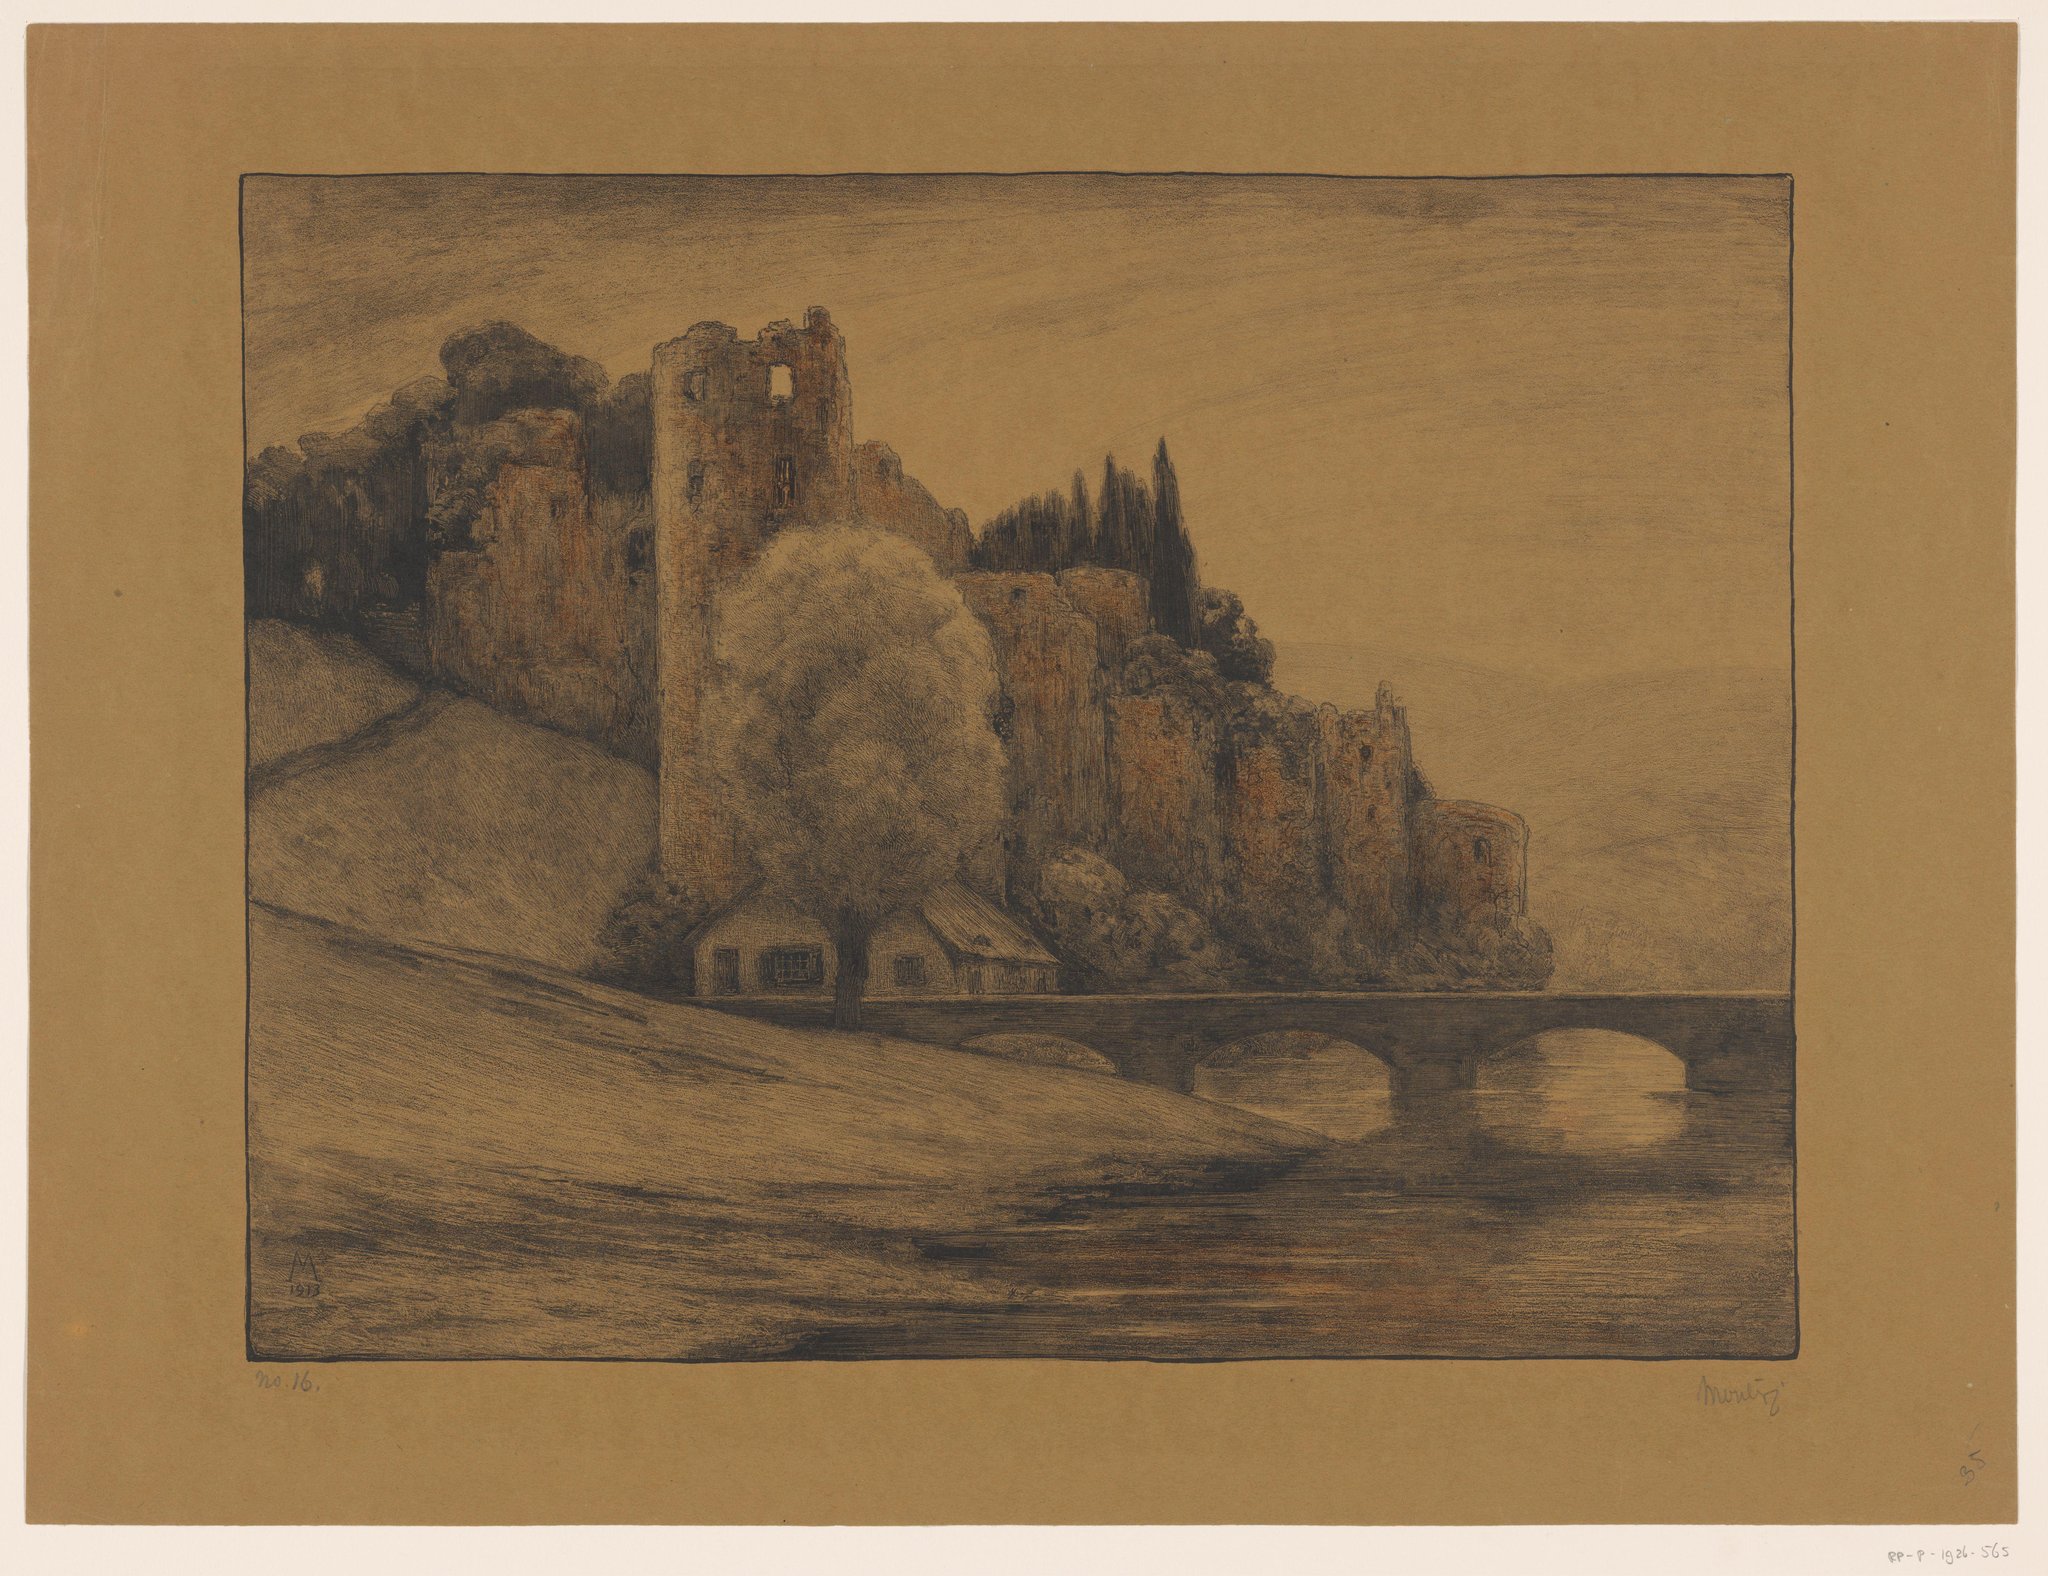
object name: print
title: Le Chateau de Beaufort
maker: simon moulijn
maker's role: draughtsman, print maker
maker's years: 1866-1948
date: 1913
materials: paper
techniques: lithograph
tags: castle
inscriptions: date